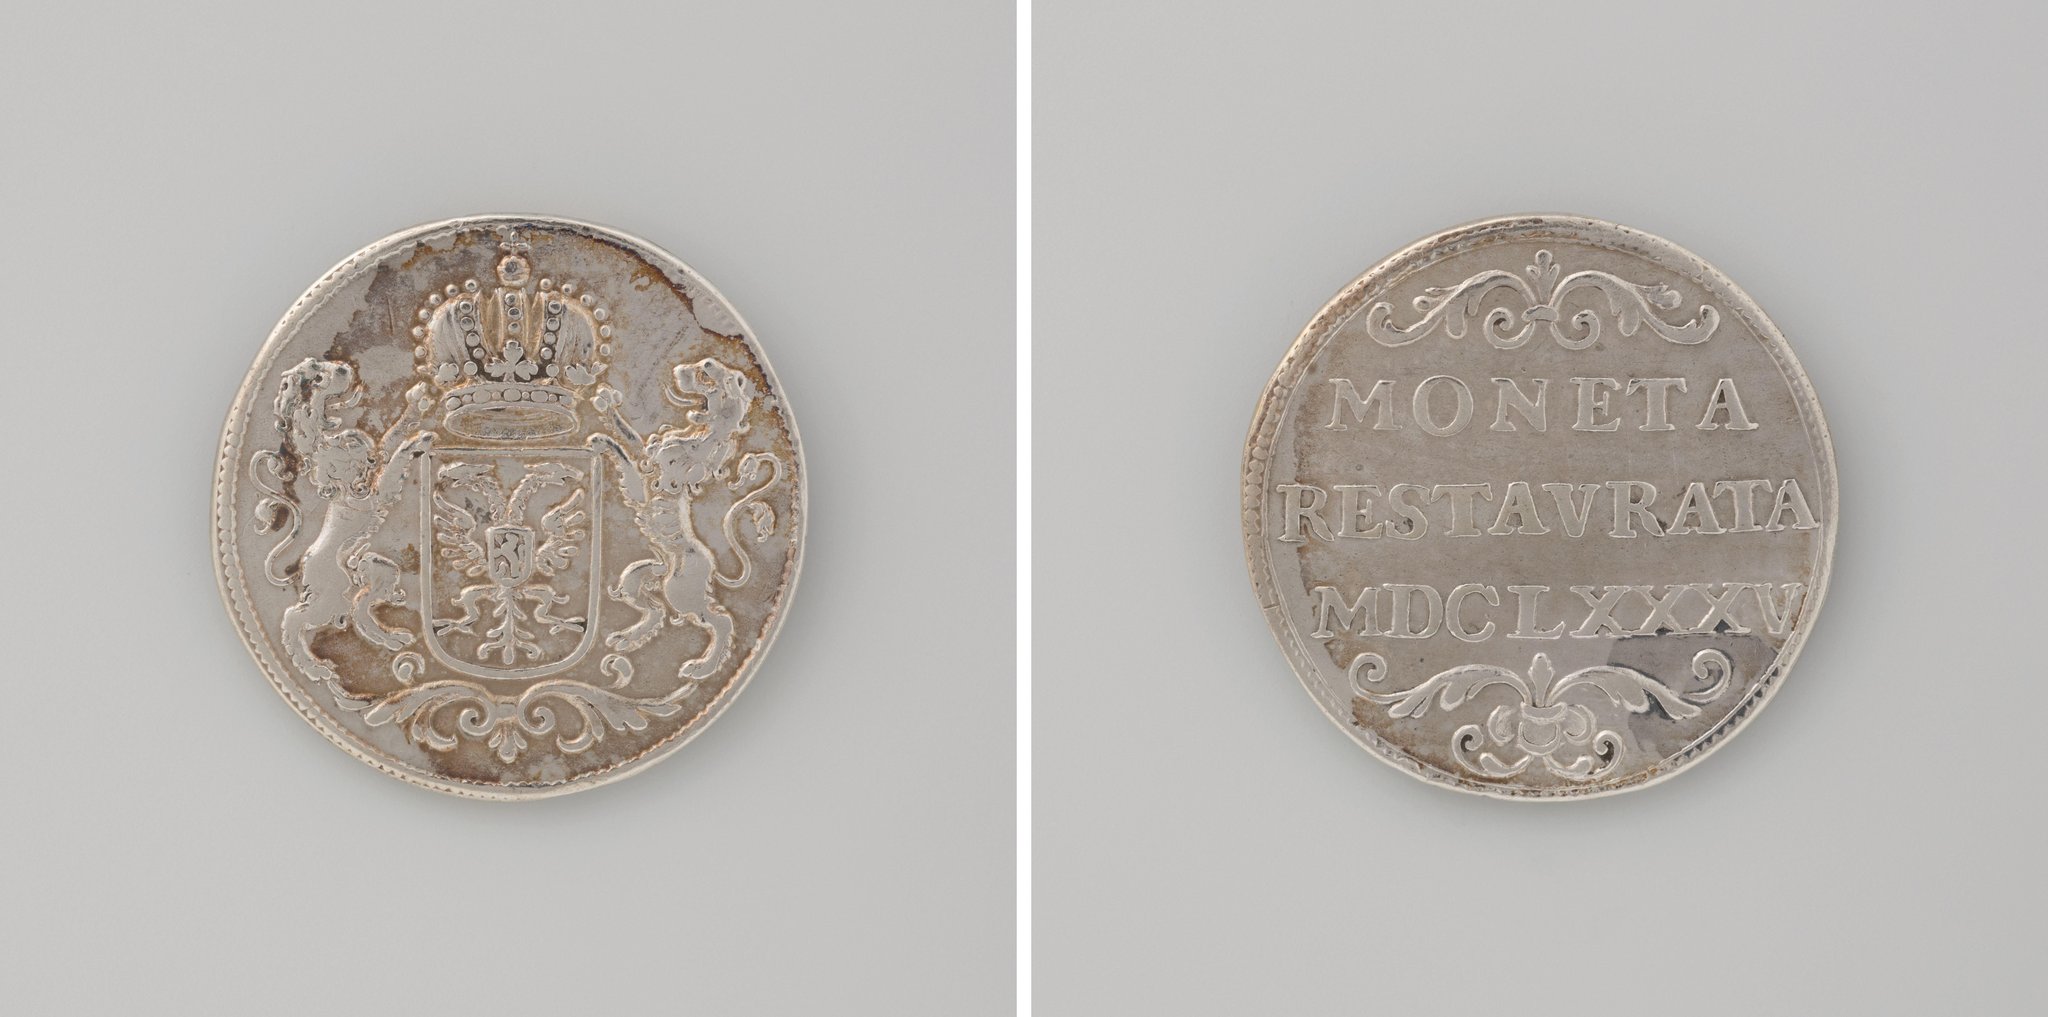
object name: history medal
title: Munt te Nijmegen hersteld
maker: gerard van harn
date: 1685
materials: silver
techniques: striking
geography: nijmegen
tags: nijmegen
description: Zilveren penning. Voorzijde: gekroond wapenschild door twee leeuwen geflankeerd. Keerzijde: opschrift.